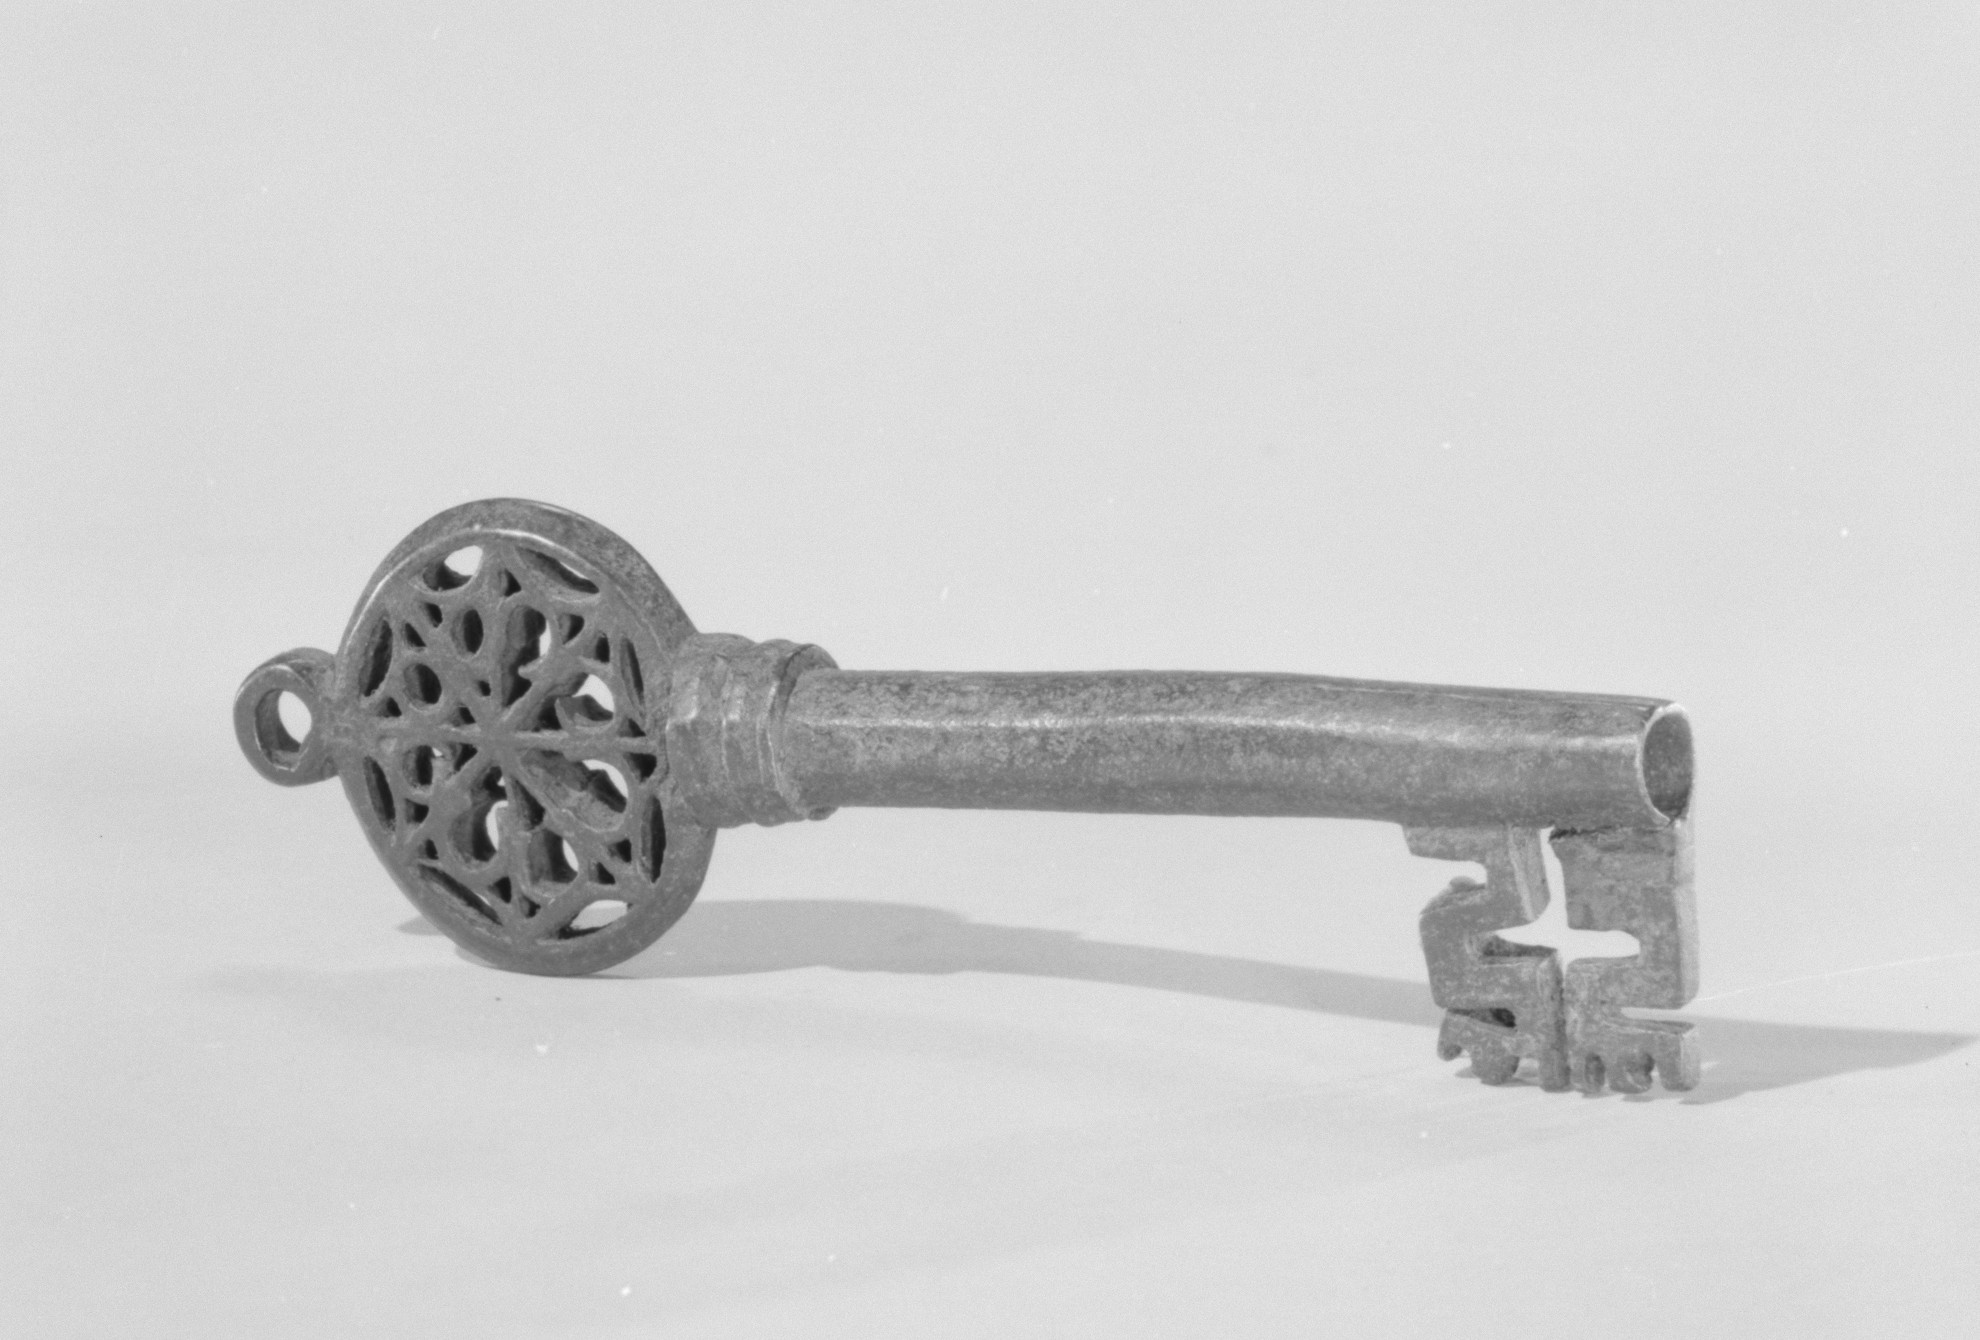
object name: coffer or chest key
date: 1501-1600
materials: iron